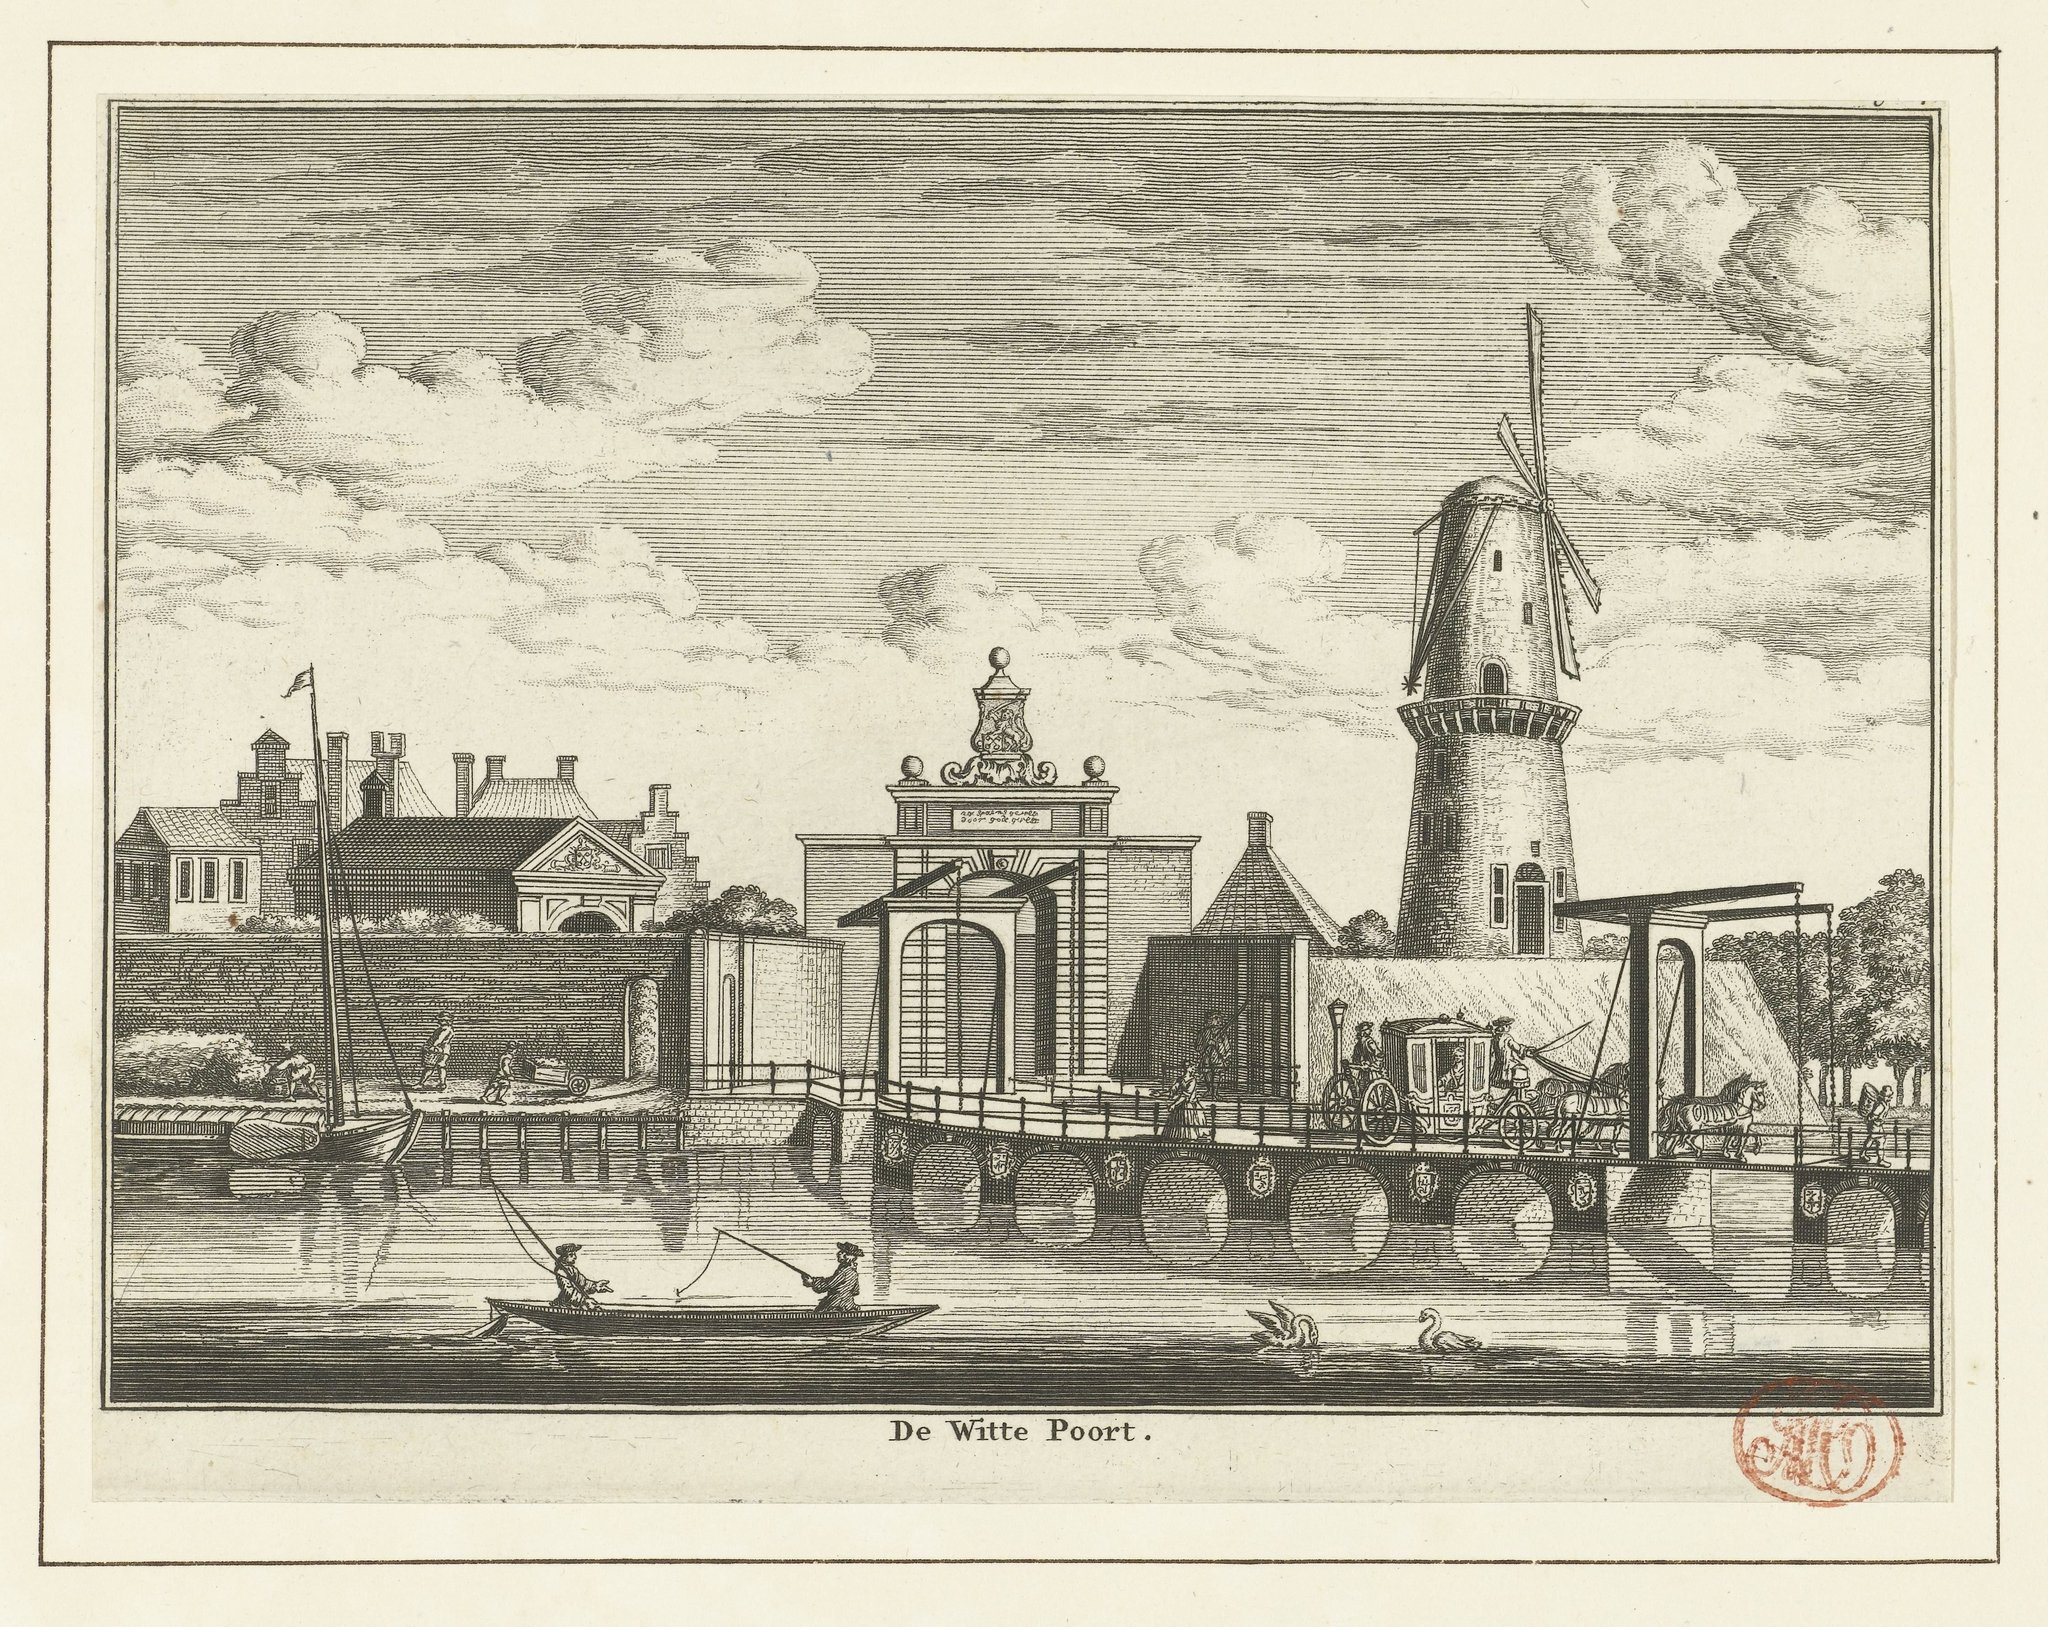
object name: book illustration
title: De Witte Poort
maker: andries van buysen (sr.)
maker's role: print maker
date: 1734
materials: paper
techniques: engraving, etching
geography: amsterdam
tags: bridge, city-gate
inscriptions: collector's mark: Lugt 195, collector's mark: Lugt 2228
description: Prent ook gebruikt in: De vermakelyke Leidsche buiten-cingels, aangenaame dorpen en landstreken, rondom die stad gelegen (…) versiert met alle de stadts-poorten. Leiden: Quirinum Visscher, Amsterdam: Arent van Huyssteen, 1734.